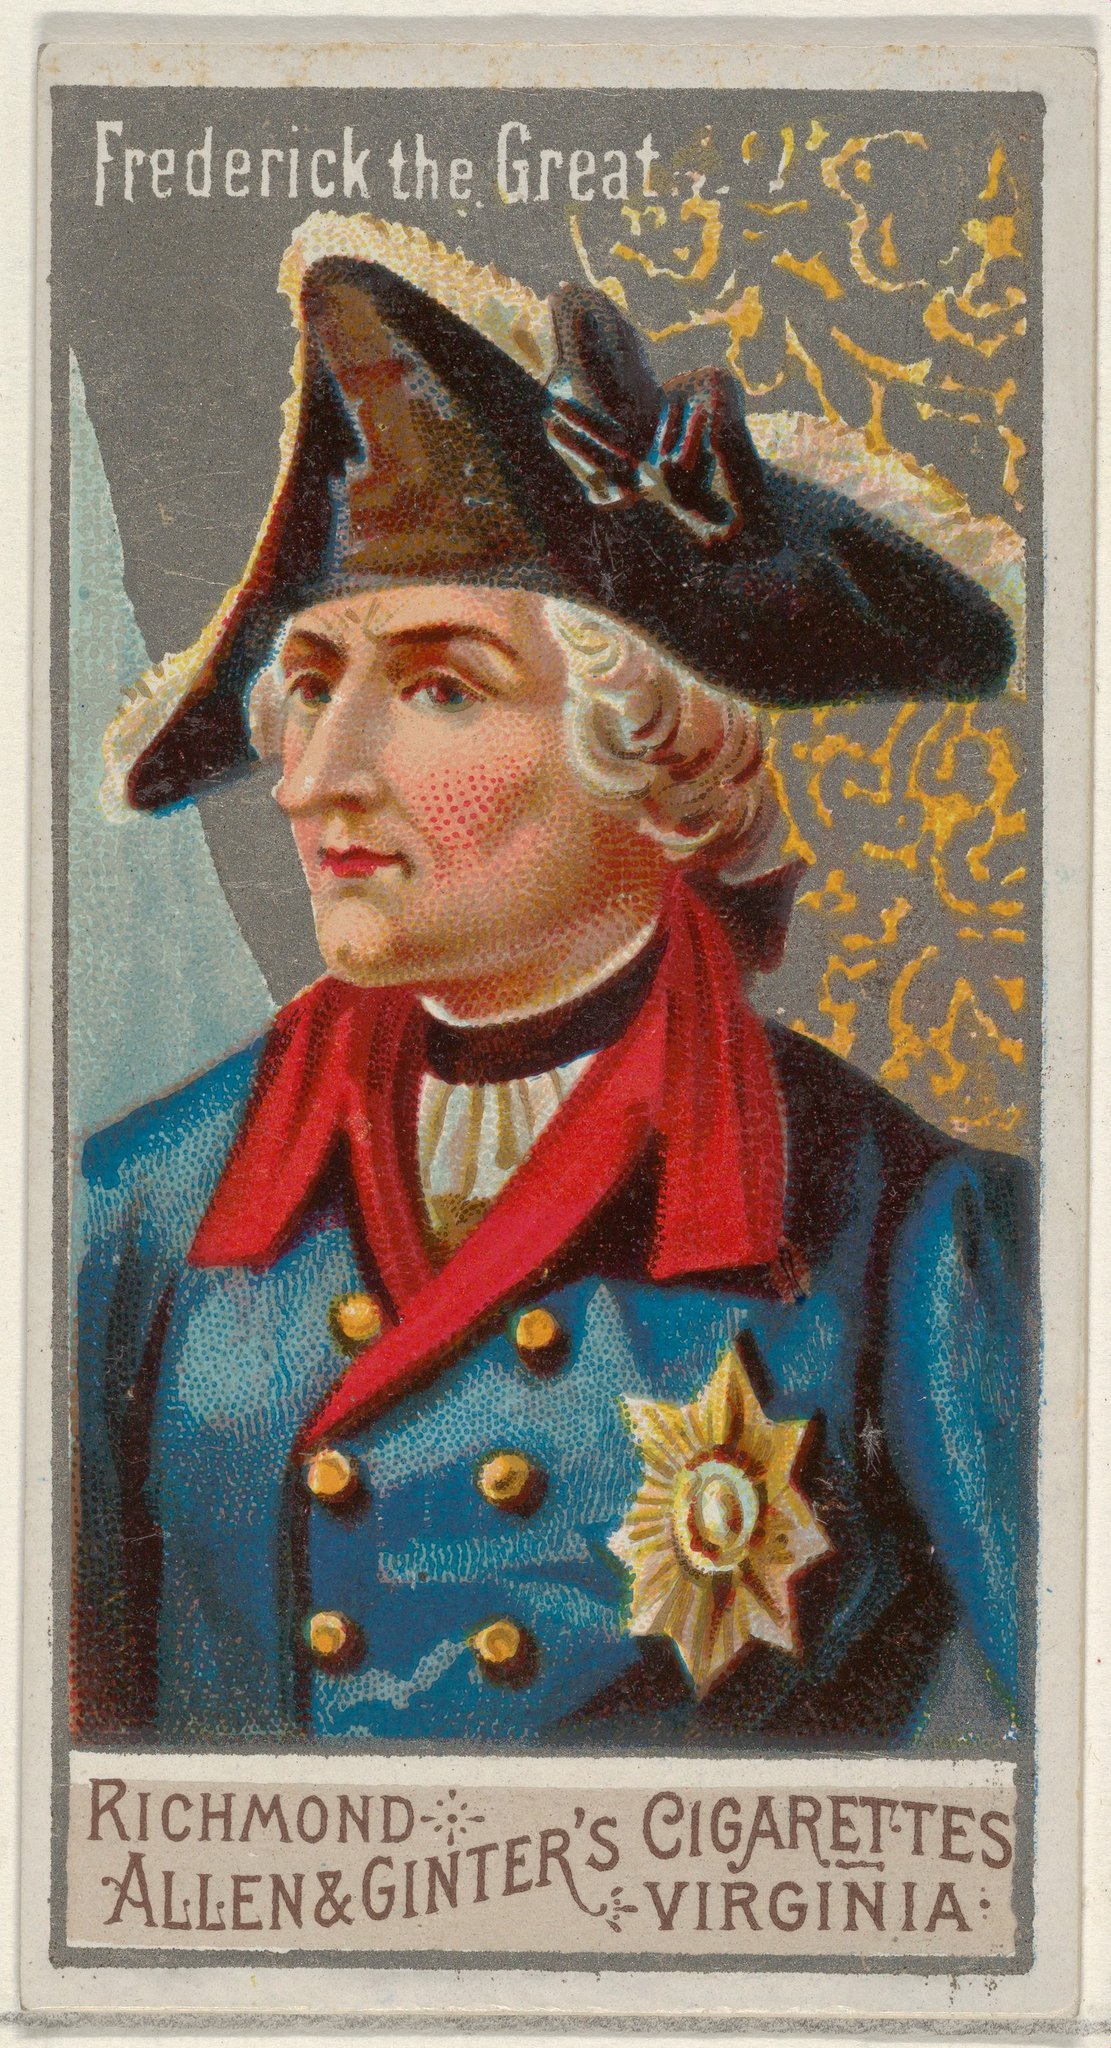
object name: print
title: Frederick the Great, from the Great Generals series (N15) for Allen & Ginter Cigarettes Brands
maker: allen & ginter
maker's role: publisher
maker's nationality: american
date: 1888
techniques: color lithograph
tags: historical figures,men,generals